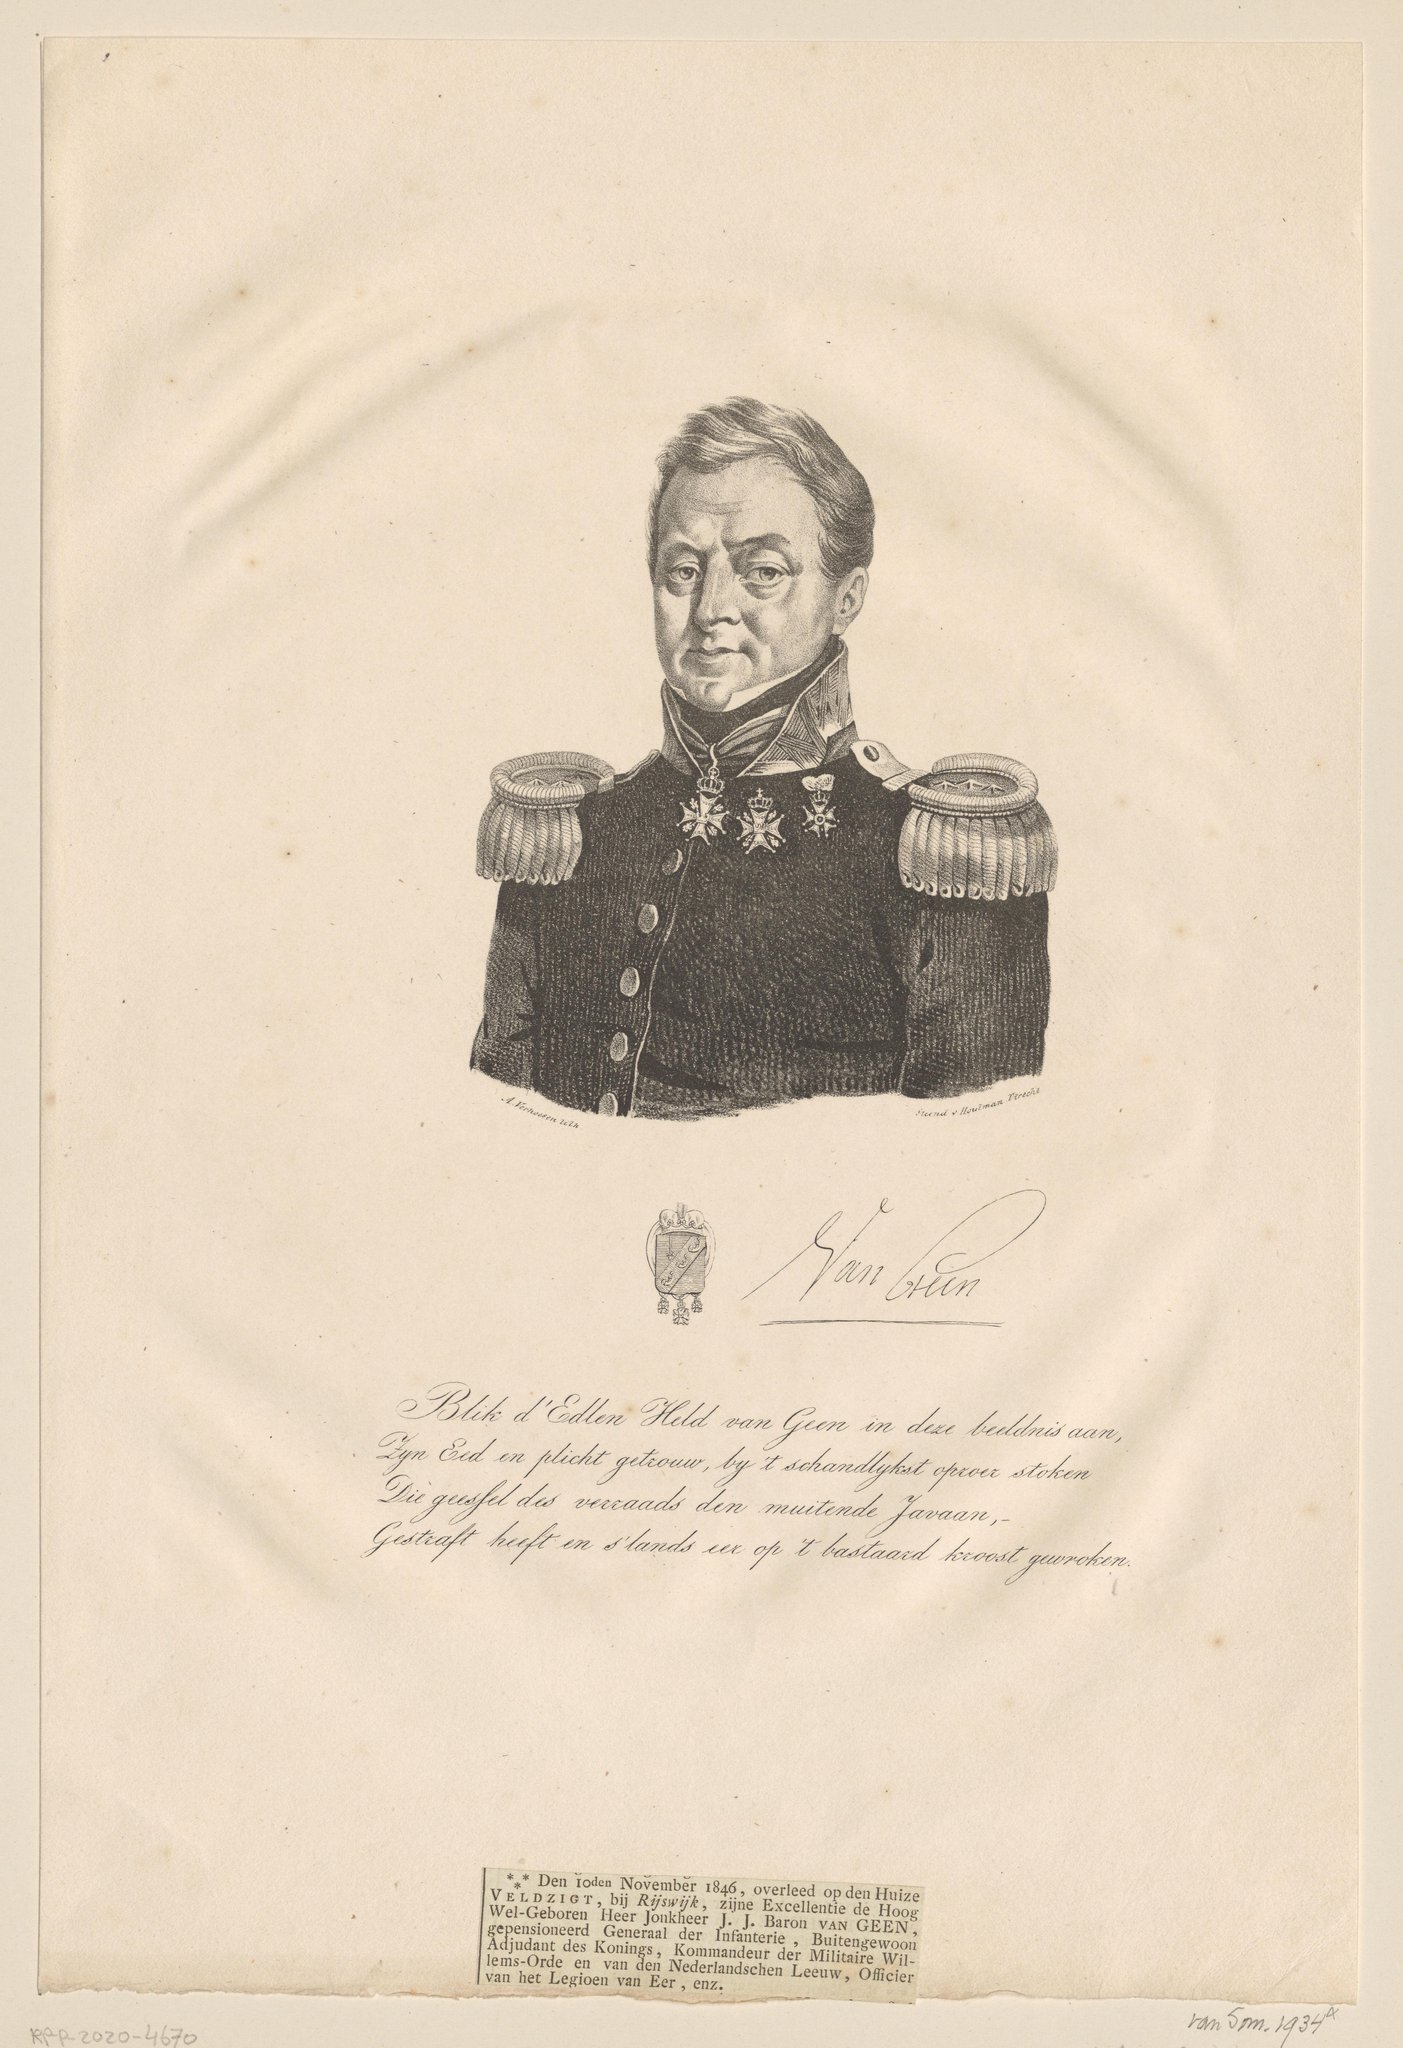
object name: print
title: Portret van Joseph Jacobus van Geen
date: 1828-1843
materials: paper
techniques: lithograph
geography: utrecht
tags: commander-in-chief, general, marshal, historical persons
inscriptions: : ‘Den 10den November 1846, overleed op den Huize/ Veldzigt, bij Rijswijk, zijne Excellentie de Hoog/Wel-Geboren Heer Jonkeer J. J. Baron van Geen,/ gepensioneerd Generaal der Infanterie, (...) Van het Legioen van Eer, enz.’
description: Tekst in boekdruk met biografische gegevens over J.J. van Geen geplakt op het blad.